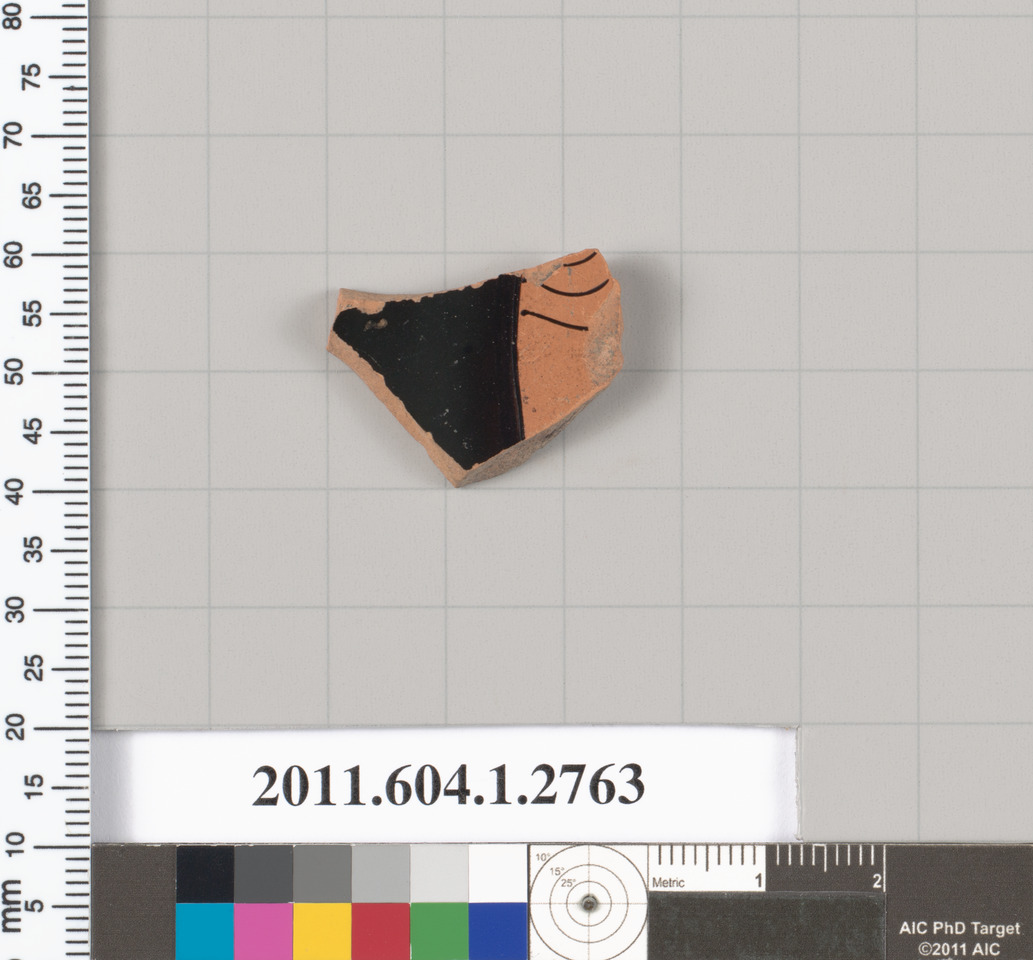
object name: kylix fragment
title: Terracotta fragment of a kylix (drinking cup)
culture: greek, attic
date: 475-451 BCE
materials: terracotta